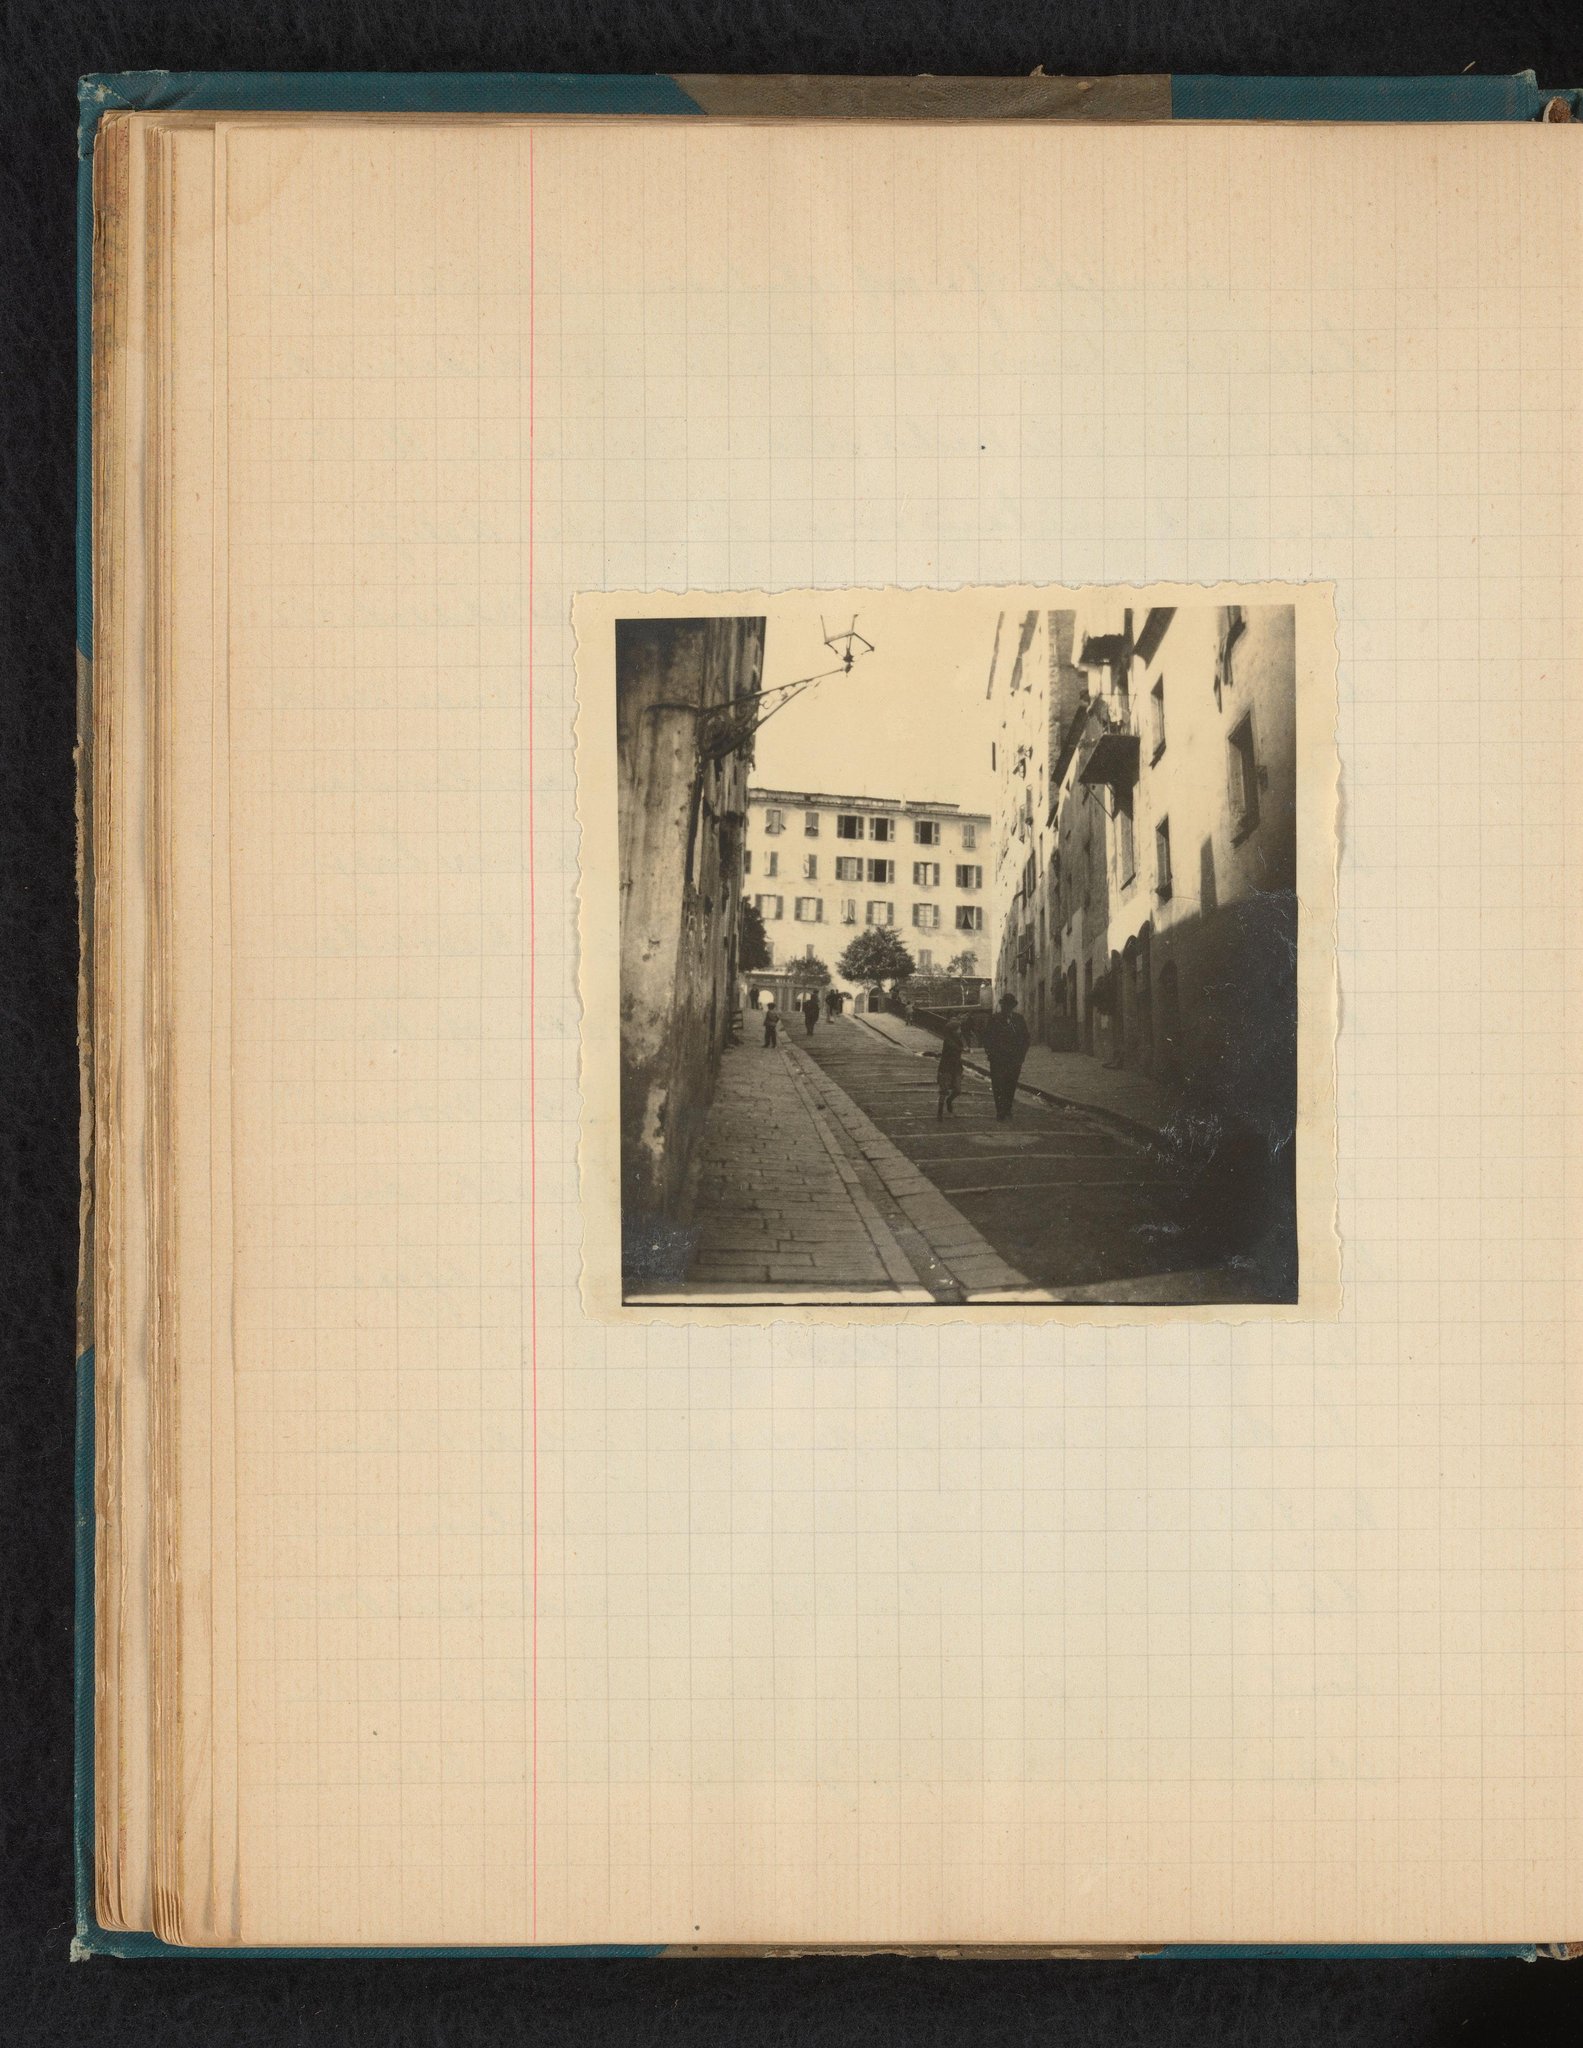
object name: photograph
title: Straatgezicht in Ajaccio, Corsica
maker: théodore van lelyveld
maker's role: painter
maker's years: 1867-1954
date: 1902-1904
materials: paper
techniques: gelatin silver print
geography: ajaccio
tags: lane, alley